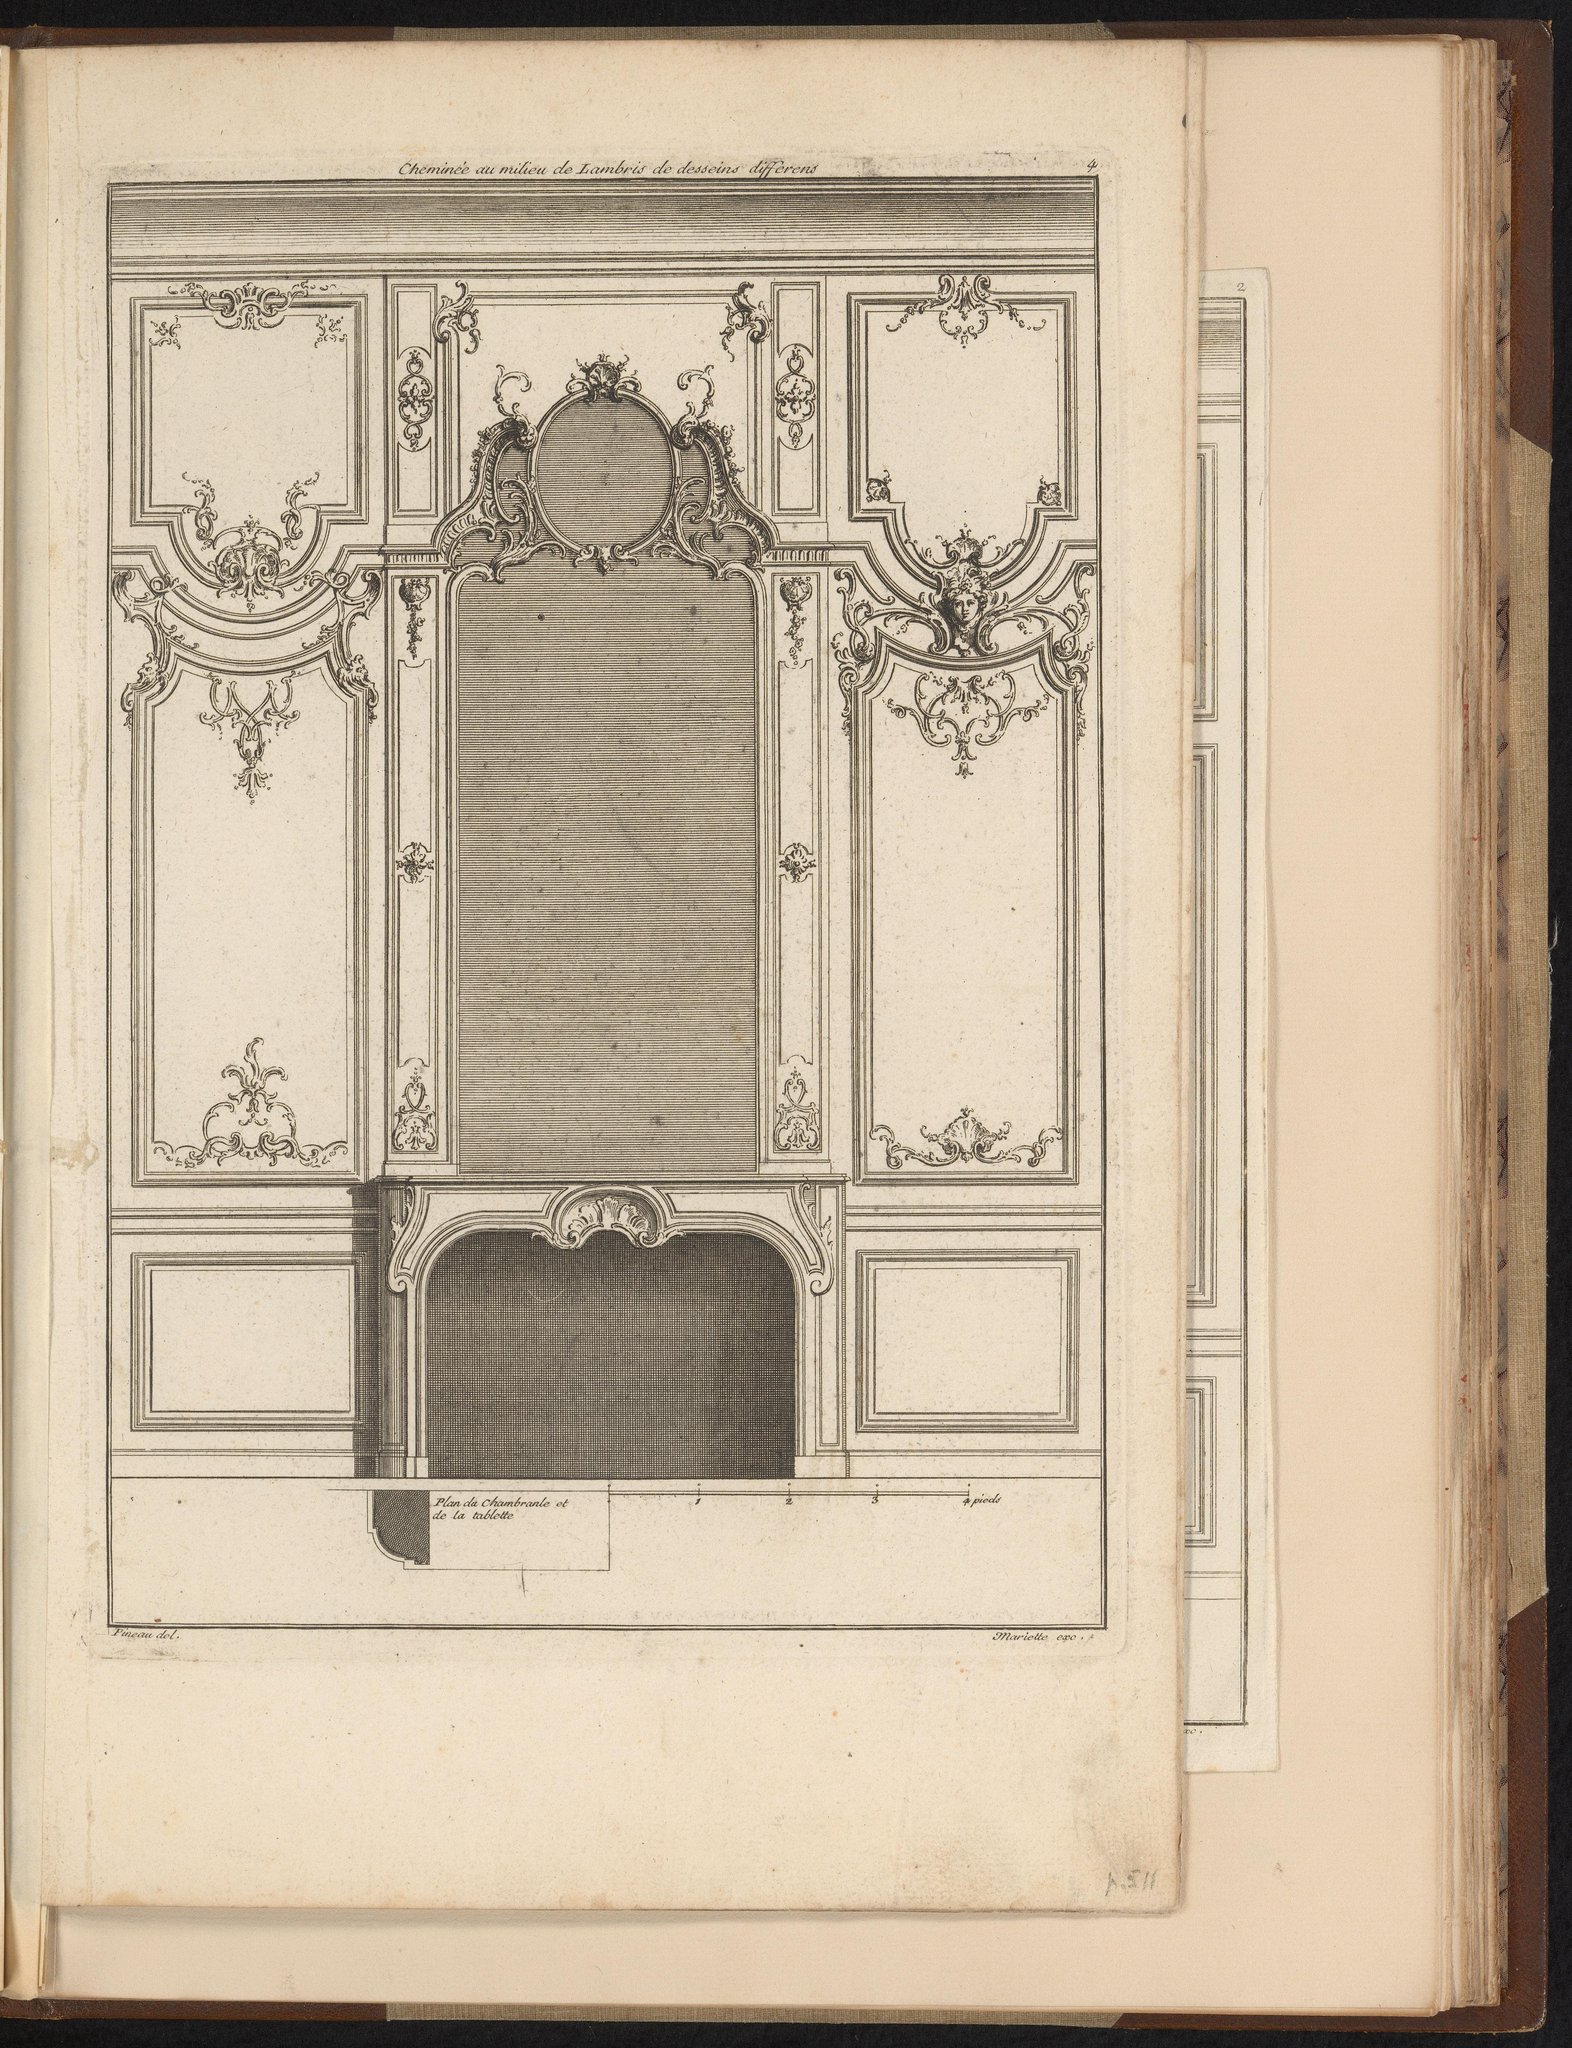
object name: print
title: Cheminée au milieu de lambris de desseins differens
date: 1725-1750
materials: paper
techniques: etching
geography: paris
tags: chimney, ornaments ~ art, panelling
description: Deze prent maakt deel uit van een album.